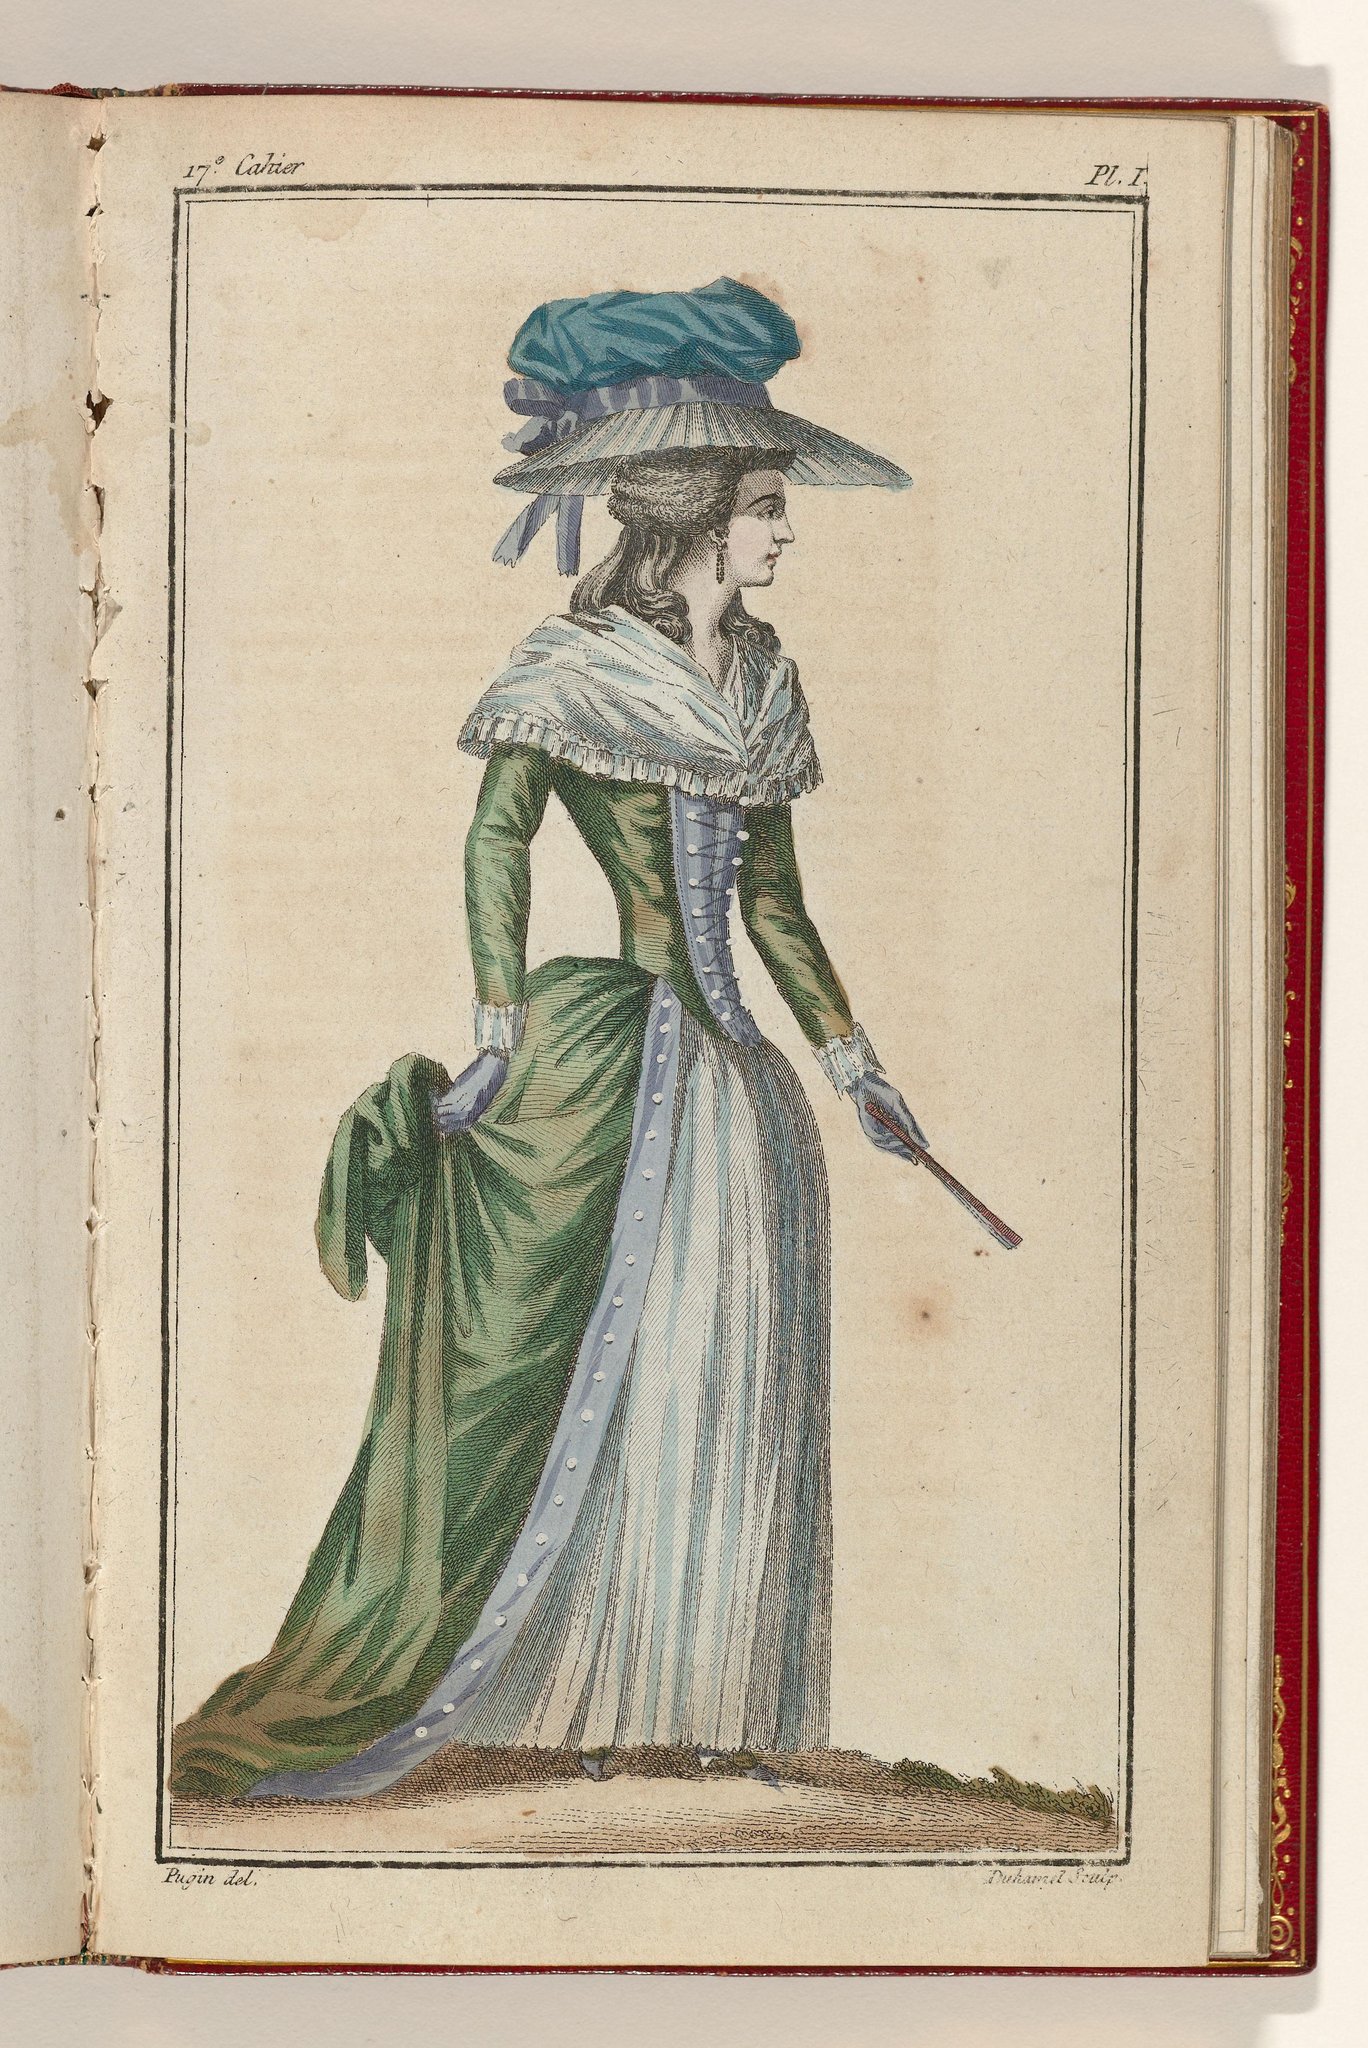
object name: fashion print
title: Cabinet des Modes ou les Modes Nouvelles, 15 Juillet 1786, pl. I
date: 1786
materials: paper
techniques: engraving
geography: paris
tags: dress, gown: robe à l'anglaise (+ women's clothes), fashion plates, fan (+ women's clothes), piece of clothing covering the breast or décolleté (fichu) (+ women's clothes)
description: Wandelende vrouw met op het hoofd een 'Chapeau-Bonnette' : hoed met brede neerwaartse randen. Om de hoge, opbollende bol een lint dat van achteren een strik vormt. Zij draagt een robe à l'Anglaise met een breed fichu en heeft een dichtgeklapte vouwwaaier in de linkerhand. Kapsel met chignon. (de tekst meldt dat het om het even is welke japon men draagt bij de ochtendwandeling, maar dat de Chapeau-Bonnette een must is)